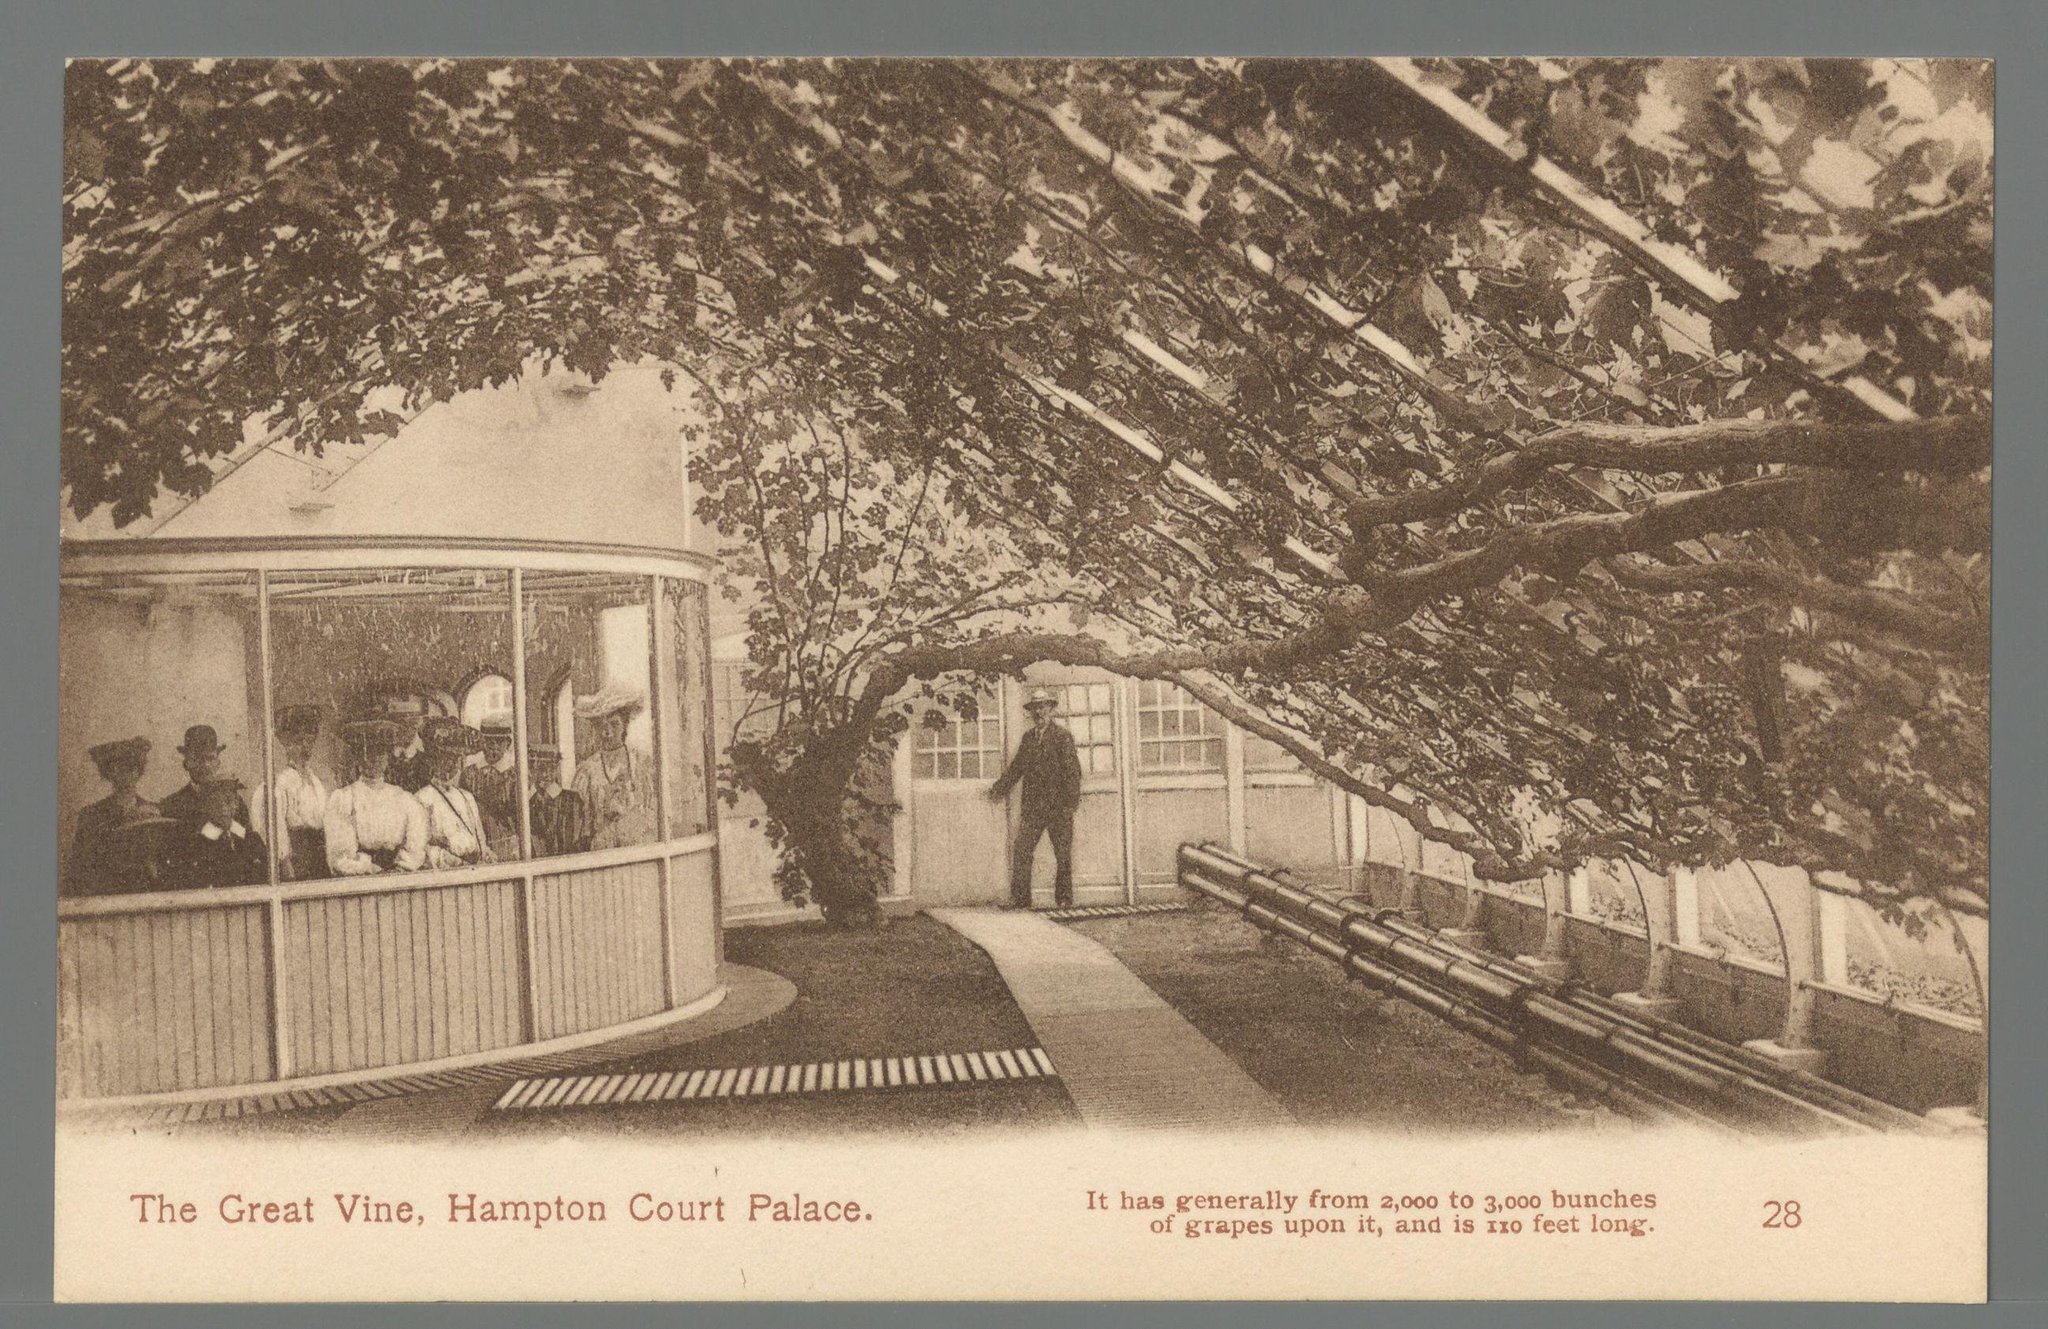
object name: photomechanical print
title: The Great Vine, Hampton Court Palace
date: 1902-1930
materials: cardboard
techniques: photograph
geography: kingston-upon-thames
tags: vine, palace